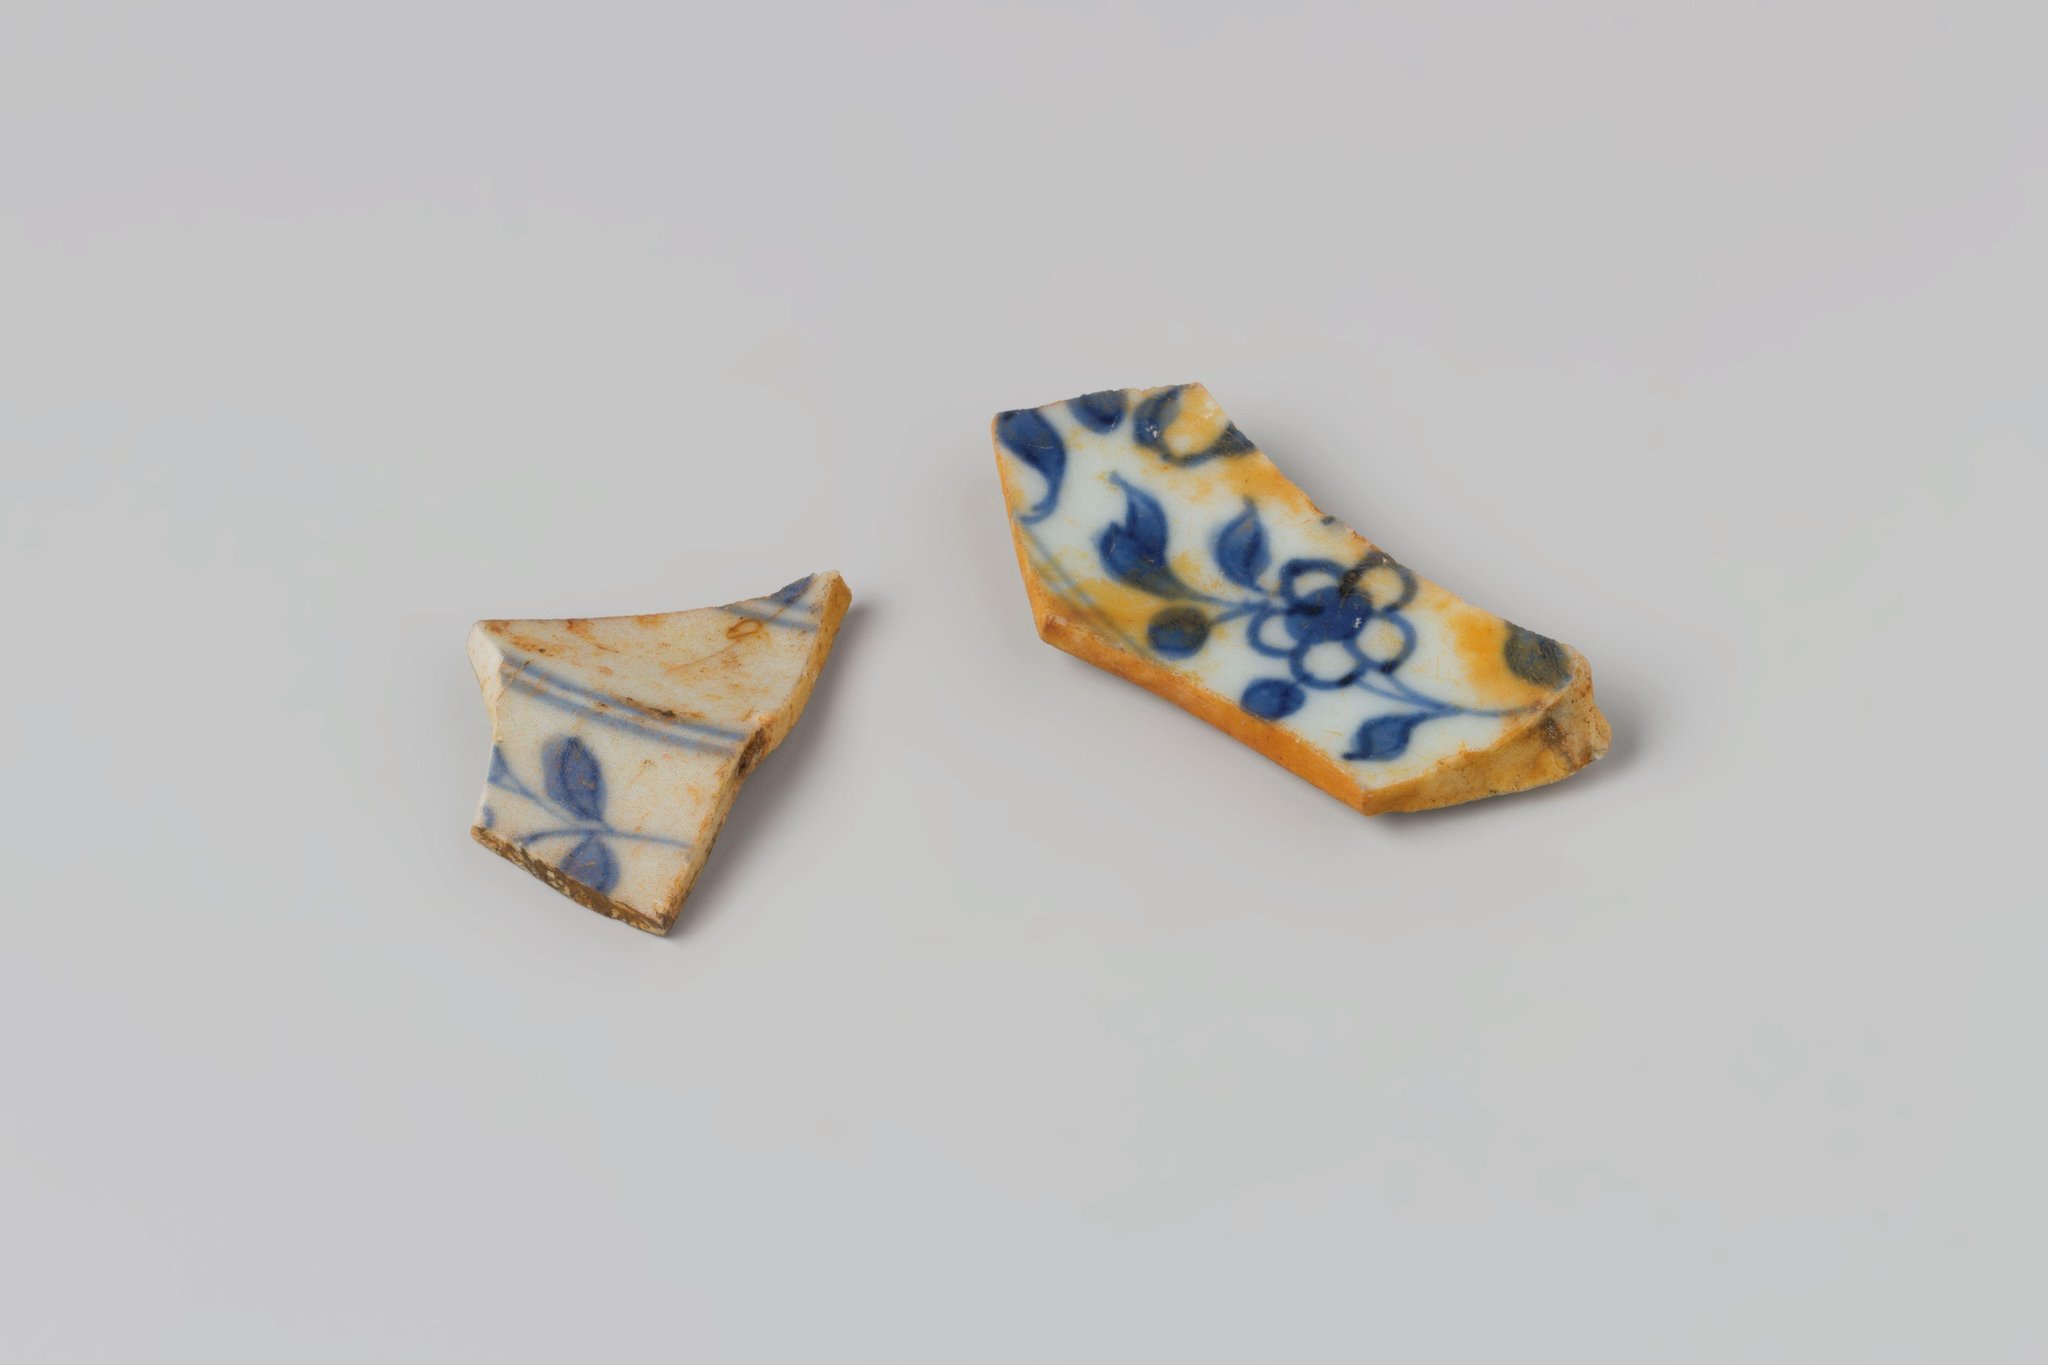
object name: plate dish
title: Scherven van borden uit het wrak van de Oost-Indiëvaarder Hollandia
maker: Anonymous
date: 1700-1743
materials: porcelain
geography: netherlands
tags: verenigde oostindische compagnie, hollandia (schip), annet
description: Porcelain, plate, type 3; fragm of base and rim, sim. NG 1980-27H3202c.